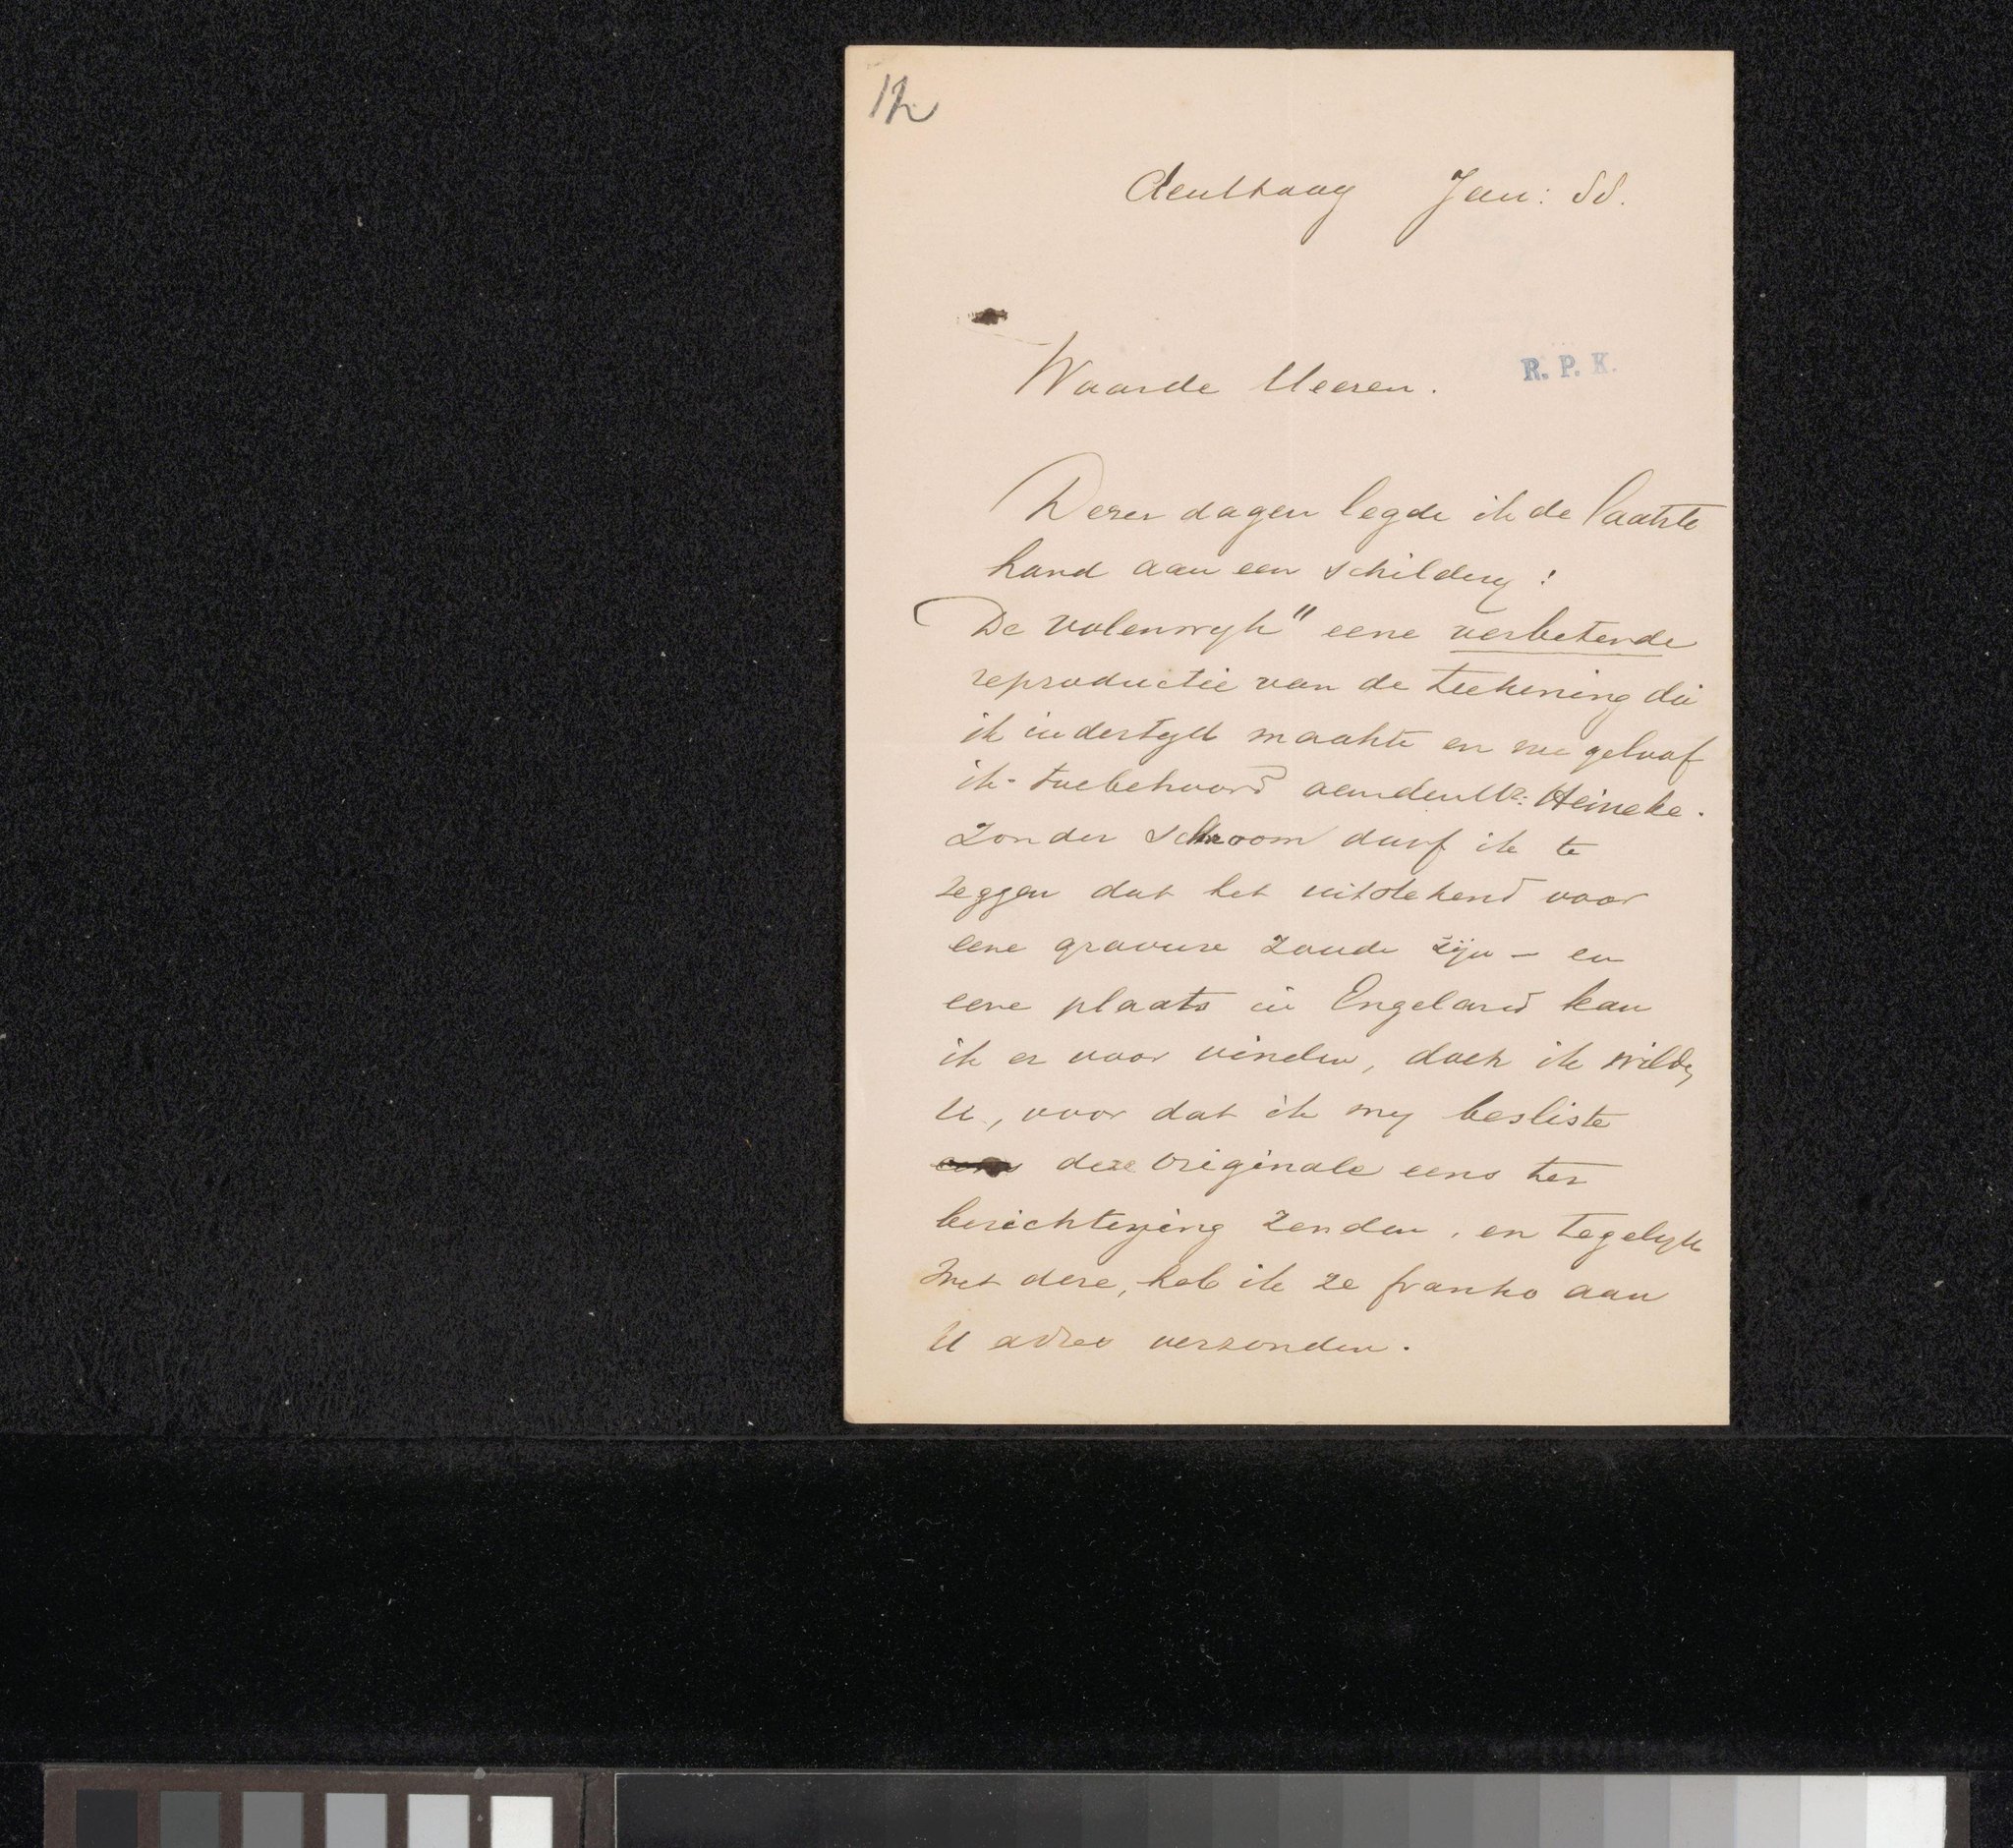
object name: letter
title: Brief aan Frans Buffa en Zonen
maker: mari ten kate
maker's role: draughtsman, painter, print maker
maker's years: 1831-1910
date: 1801-1888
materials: ink, paper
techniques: pen, writing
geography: the hague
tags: publisher, drawing, the graphic arts, painting (including book-illumination, miniature-painting), england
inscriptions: collector's mark: Lugt 2233